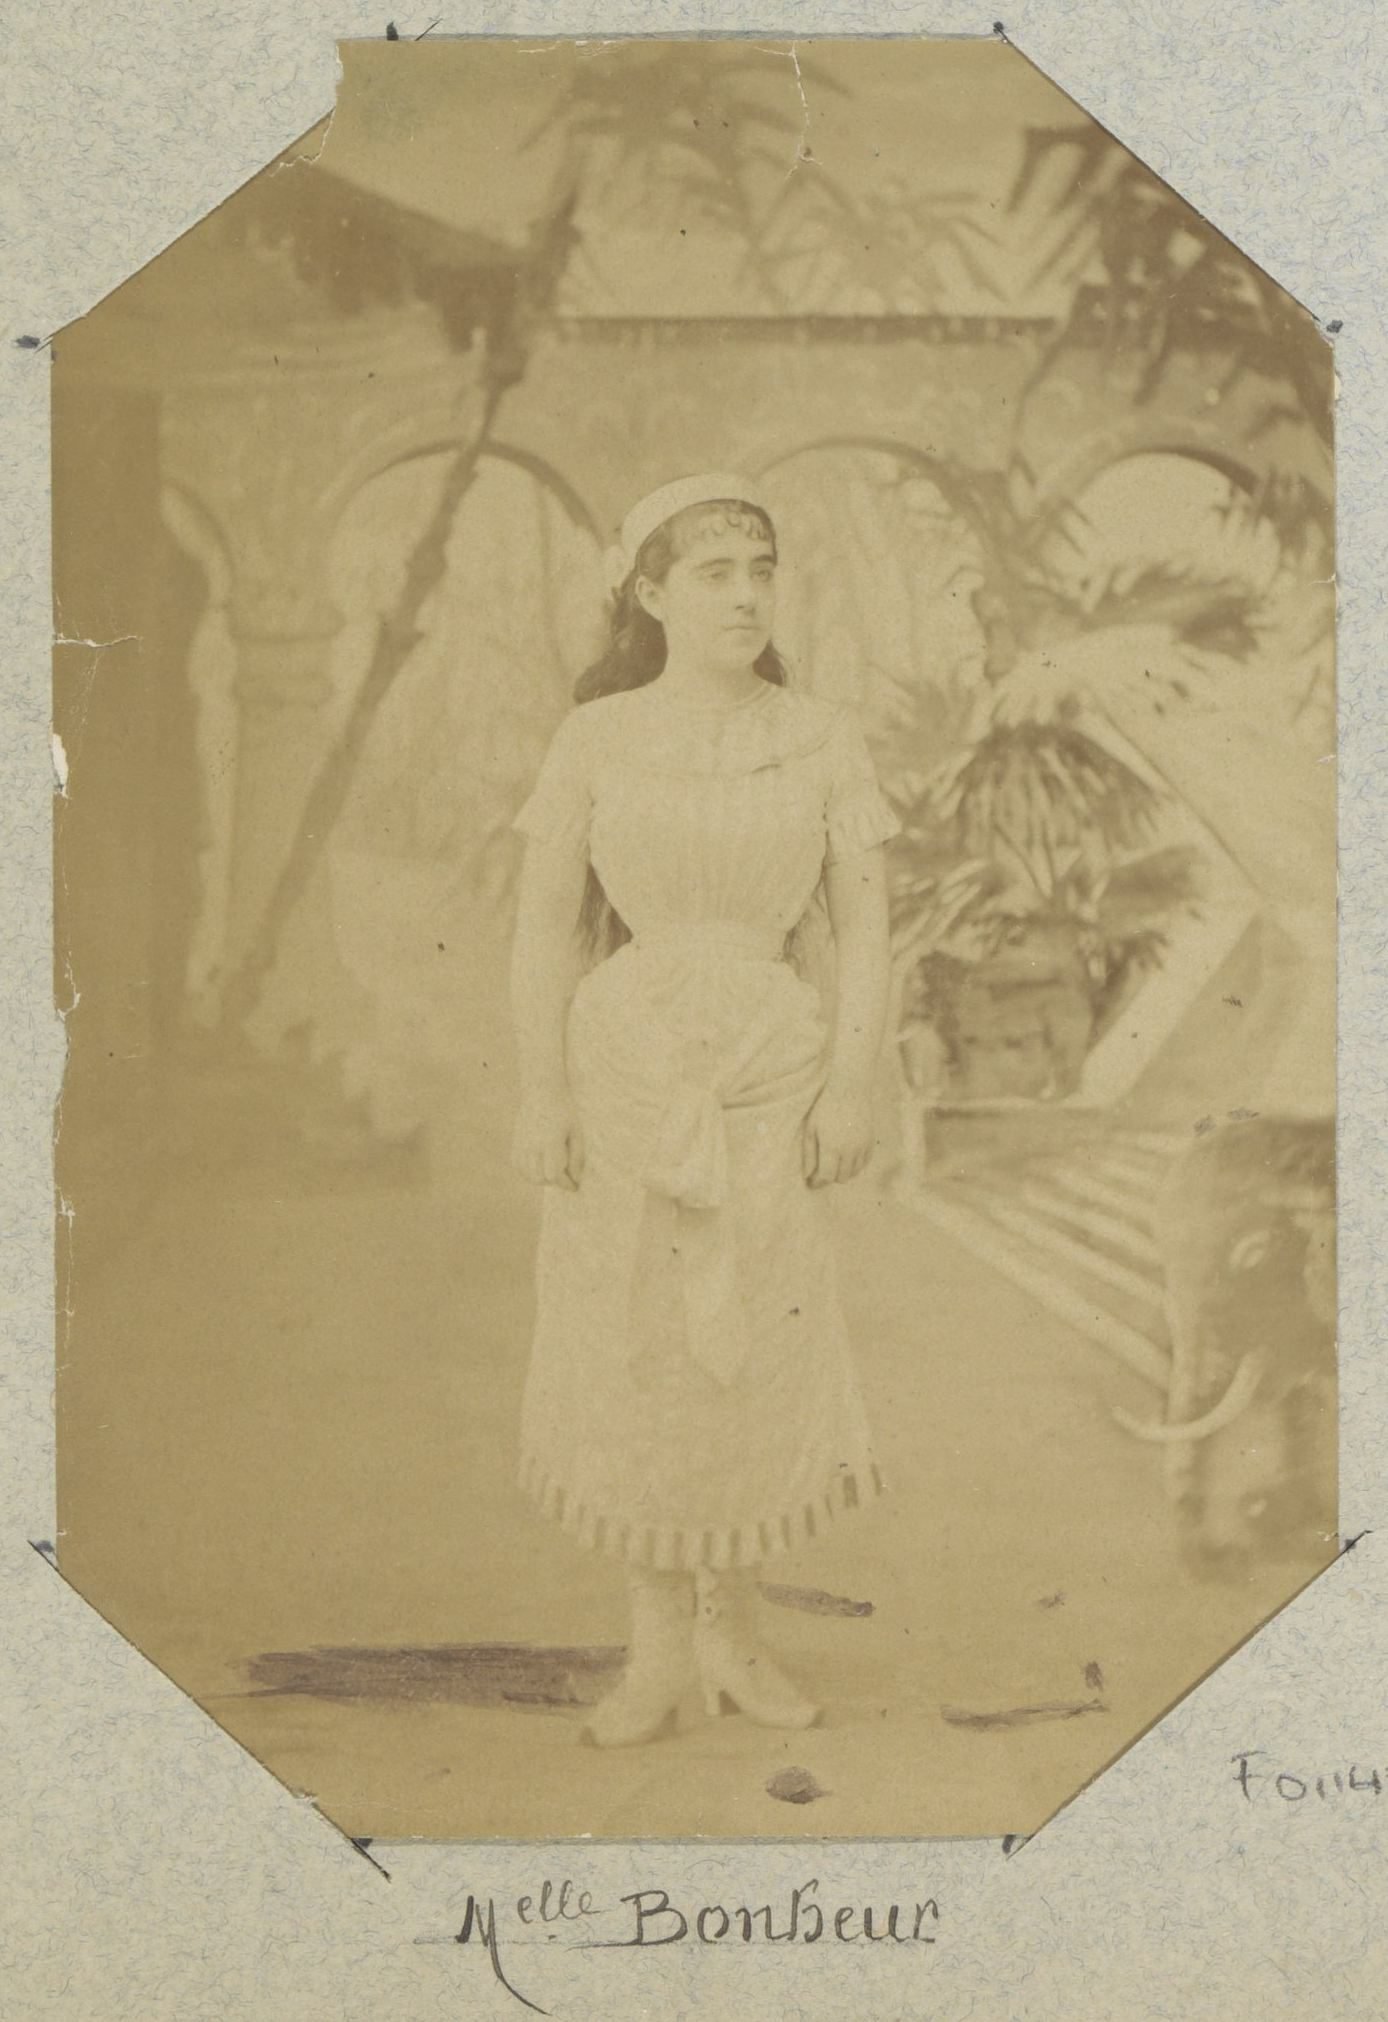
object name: photograph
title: Portret van Mademoiselle Bonheur, vermoedelijk actrice of zangeres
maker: Anonymous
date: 1880-1900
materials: paper, photographic support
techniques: albumen print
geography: paris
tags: president ~ head of republic, politician, e.g. party leader, france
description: Onderdeel van Album van een Franse amateur met foto's van Frankrijk, Algerije, Palmyra, de Wereldtentoonstelling van 1900 en van bekende Fransen.